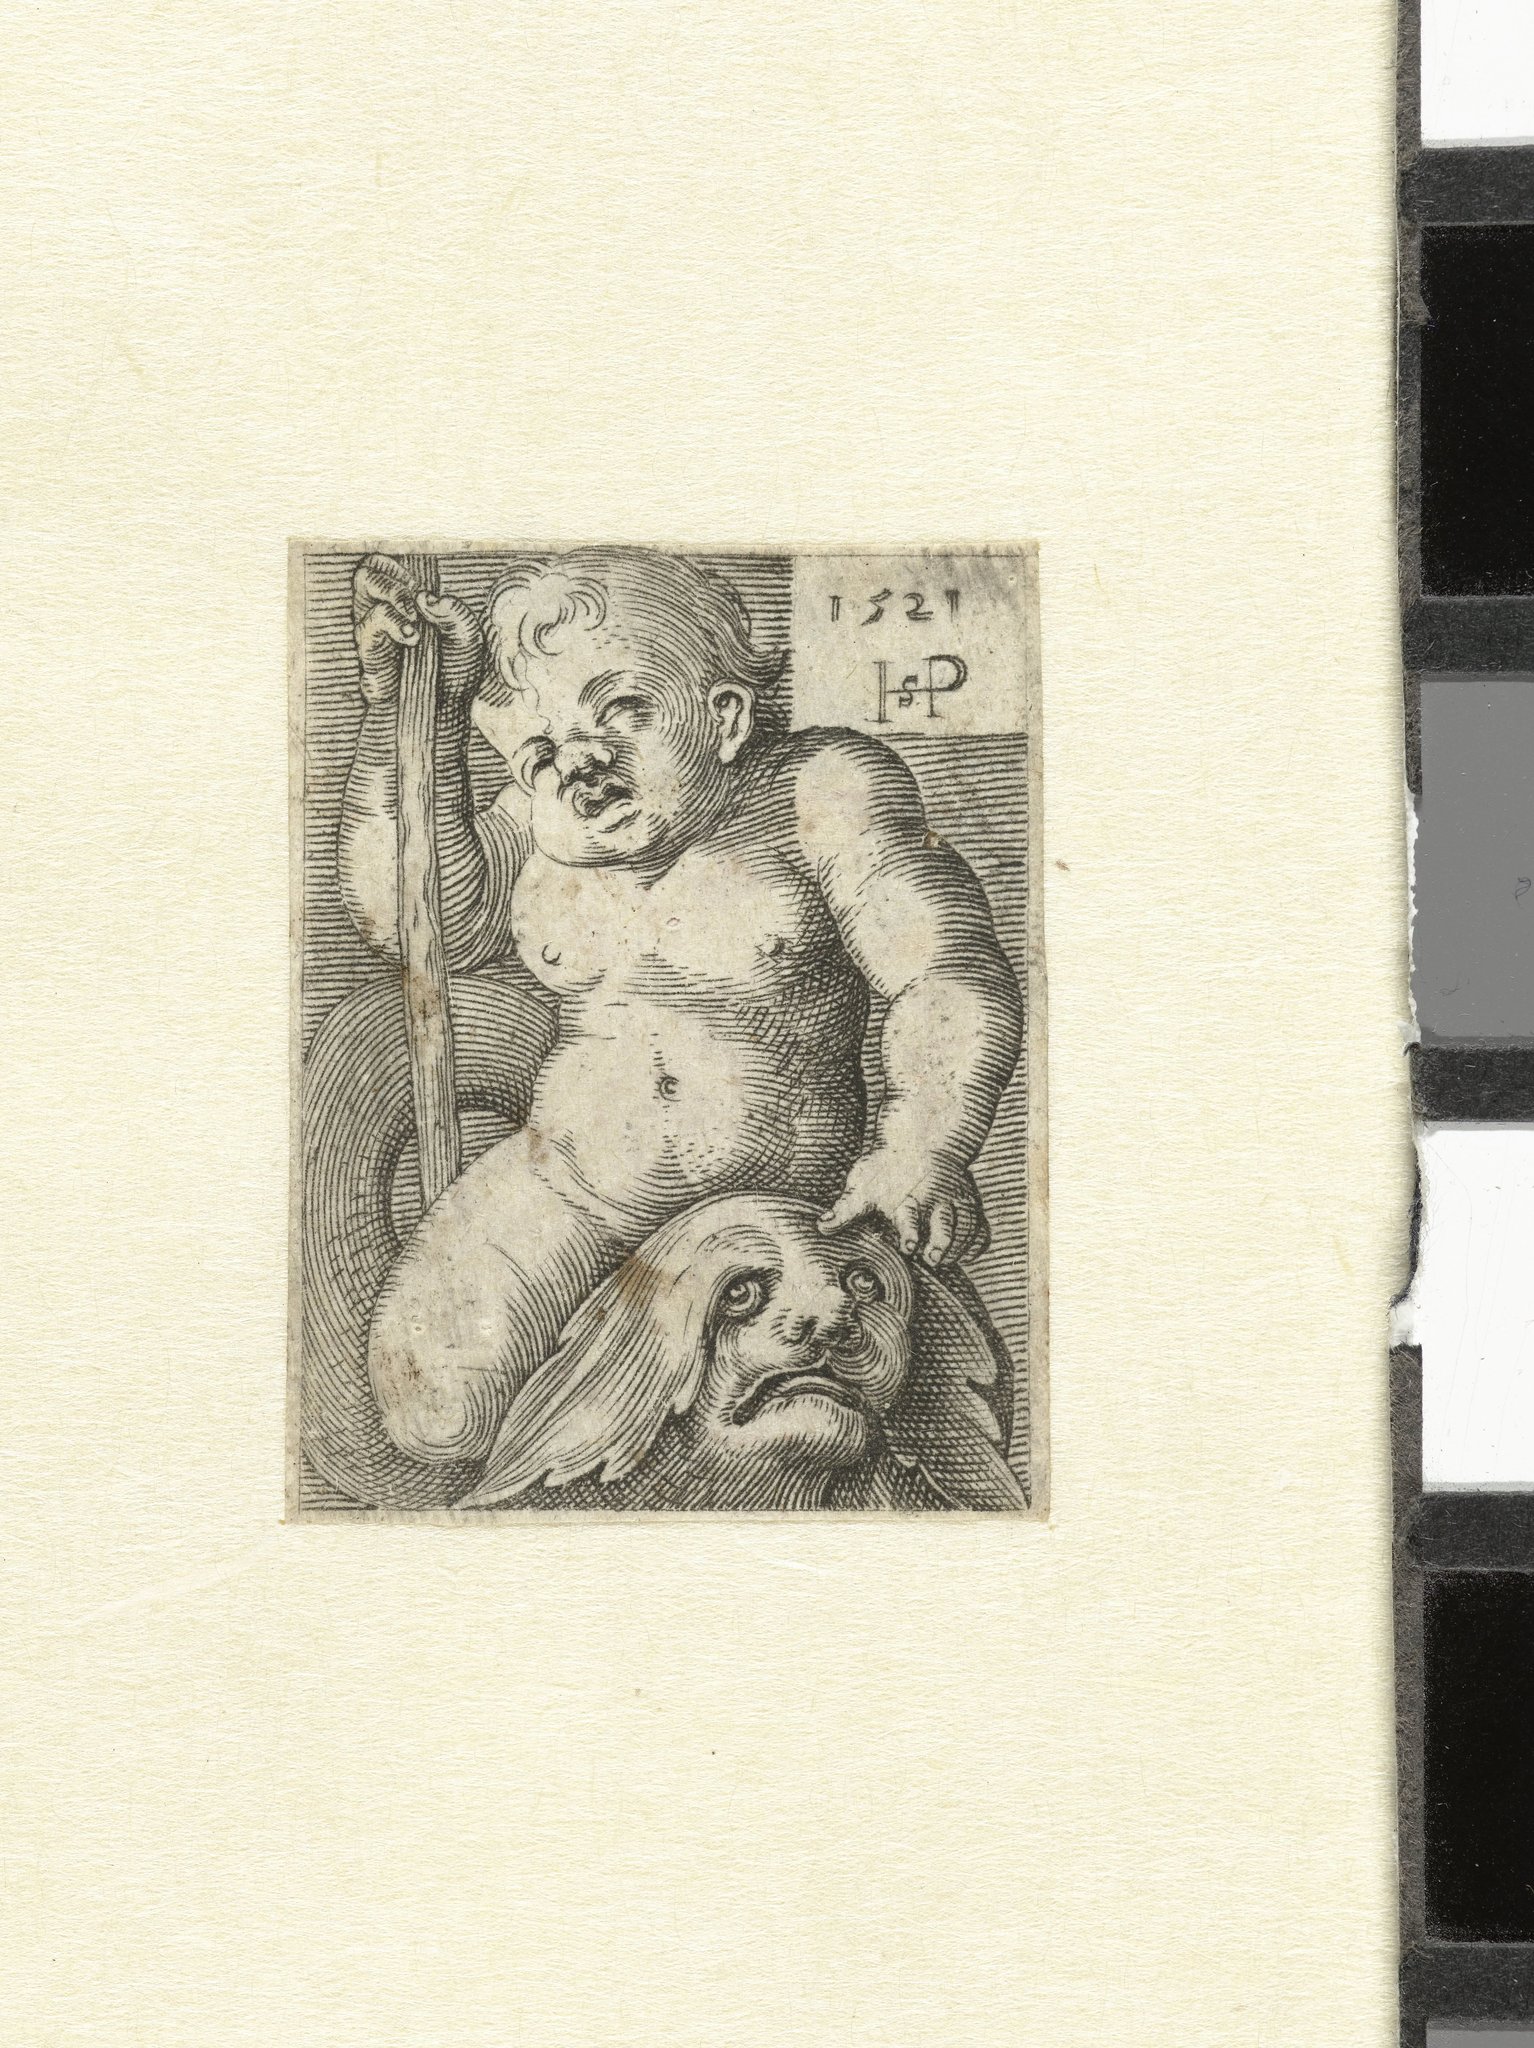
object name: print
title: Putto op een dolfijn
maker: Anonymous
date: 1521-1599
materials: paper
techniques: engraving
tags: fabulous animals ~ domestic animals, cupids: 'amores', 'amoretti', 'putti'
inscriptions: collector's mark: Lugt 240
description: Kopie in spiegelbeeld naar een prent van Hans Sebald Beham.